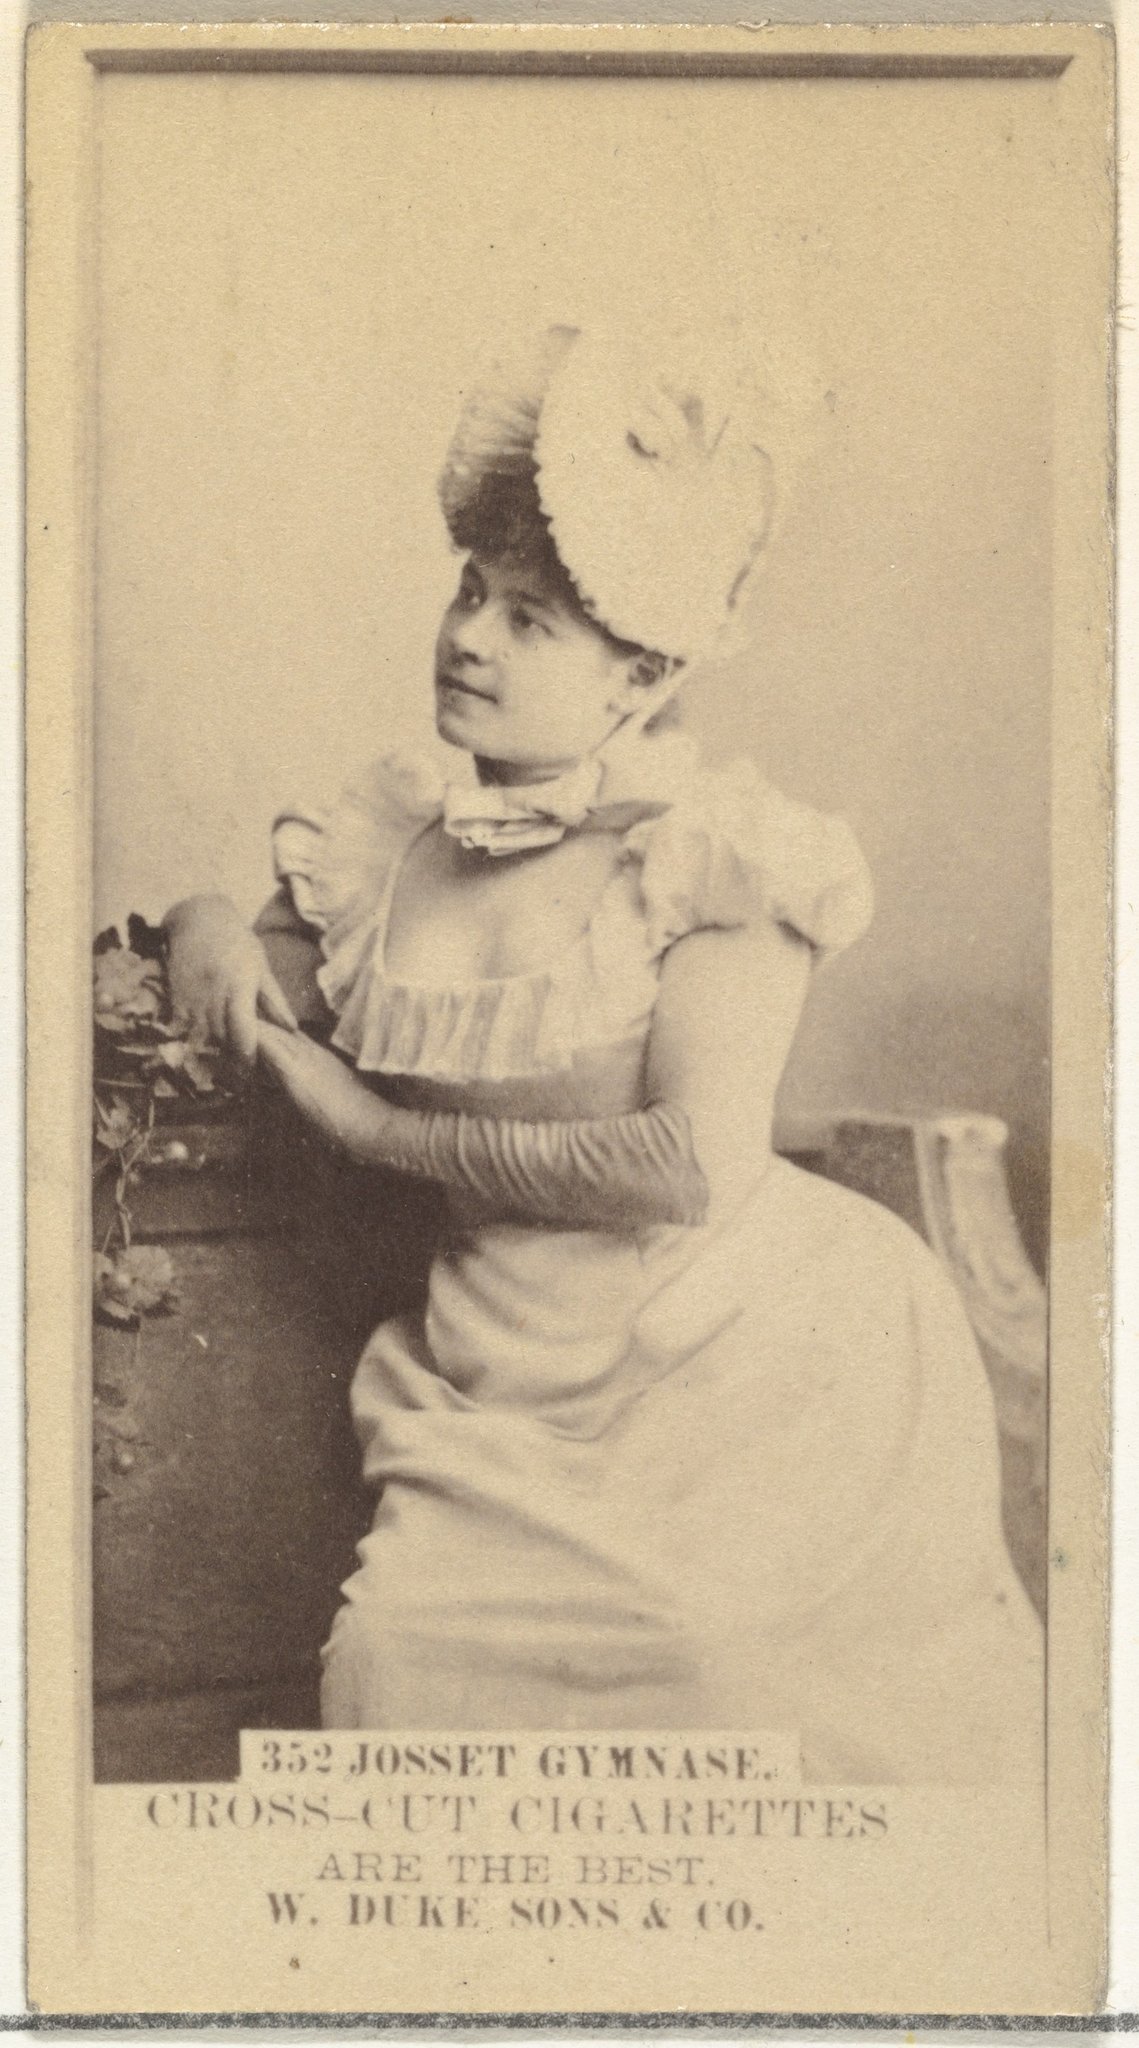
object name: photograph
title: Card Number 352, Josset Gymnase, from the Actors and Actresses series (N145-3) issued by Duke Sons & Co. to promote Cross Cut Cigarettes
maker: w. duke, sons & co.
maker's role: publisher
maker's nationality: american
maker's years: 1870-1920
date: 1880-1889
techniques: albumen silver print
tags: portraits,women,actresses